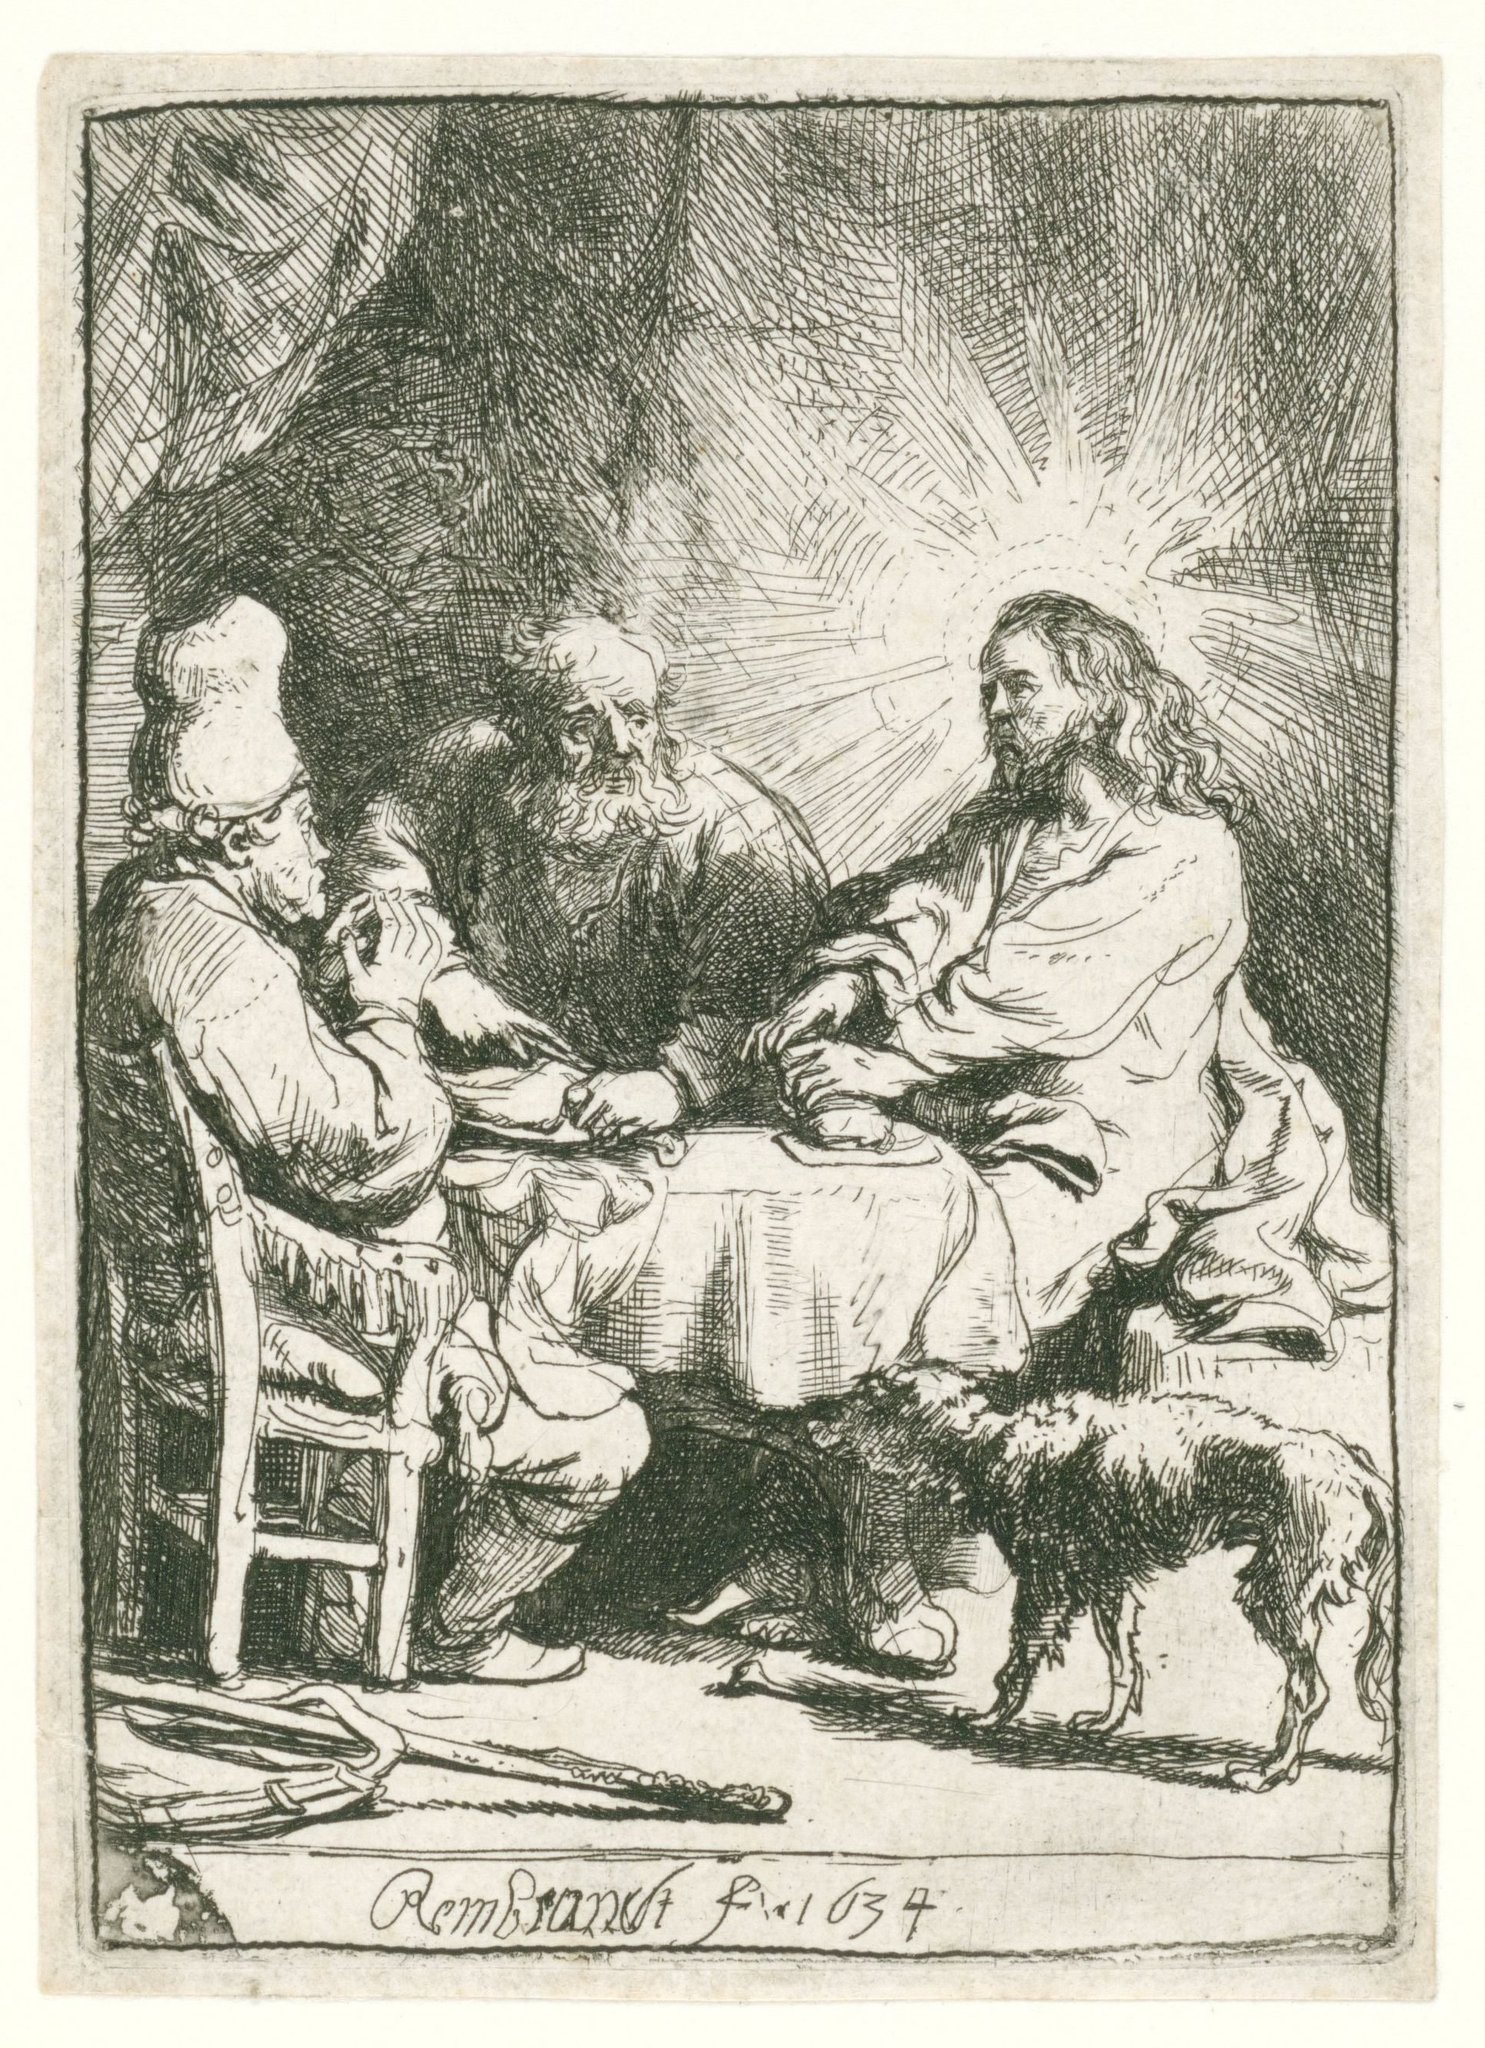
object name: print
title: Christ at Emmaus: the smaller plate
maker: rembrandt van rijn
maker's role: draughtsman, painter, print maker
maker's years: 1606-1669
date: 1634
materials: paper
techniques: drypoint, etching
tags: the supper at emmaus: christ is recognized while blessing or breaking the bread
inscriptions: inscription: ‘Jan Veth’, collector's mark: Lugt 2228, signature and date: ‘Rembrandt f. 1634’